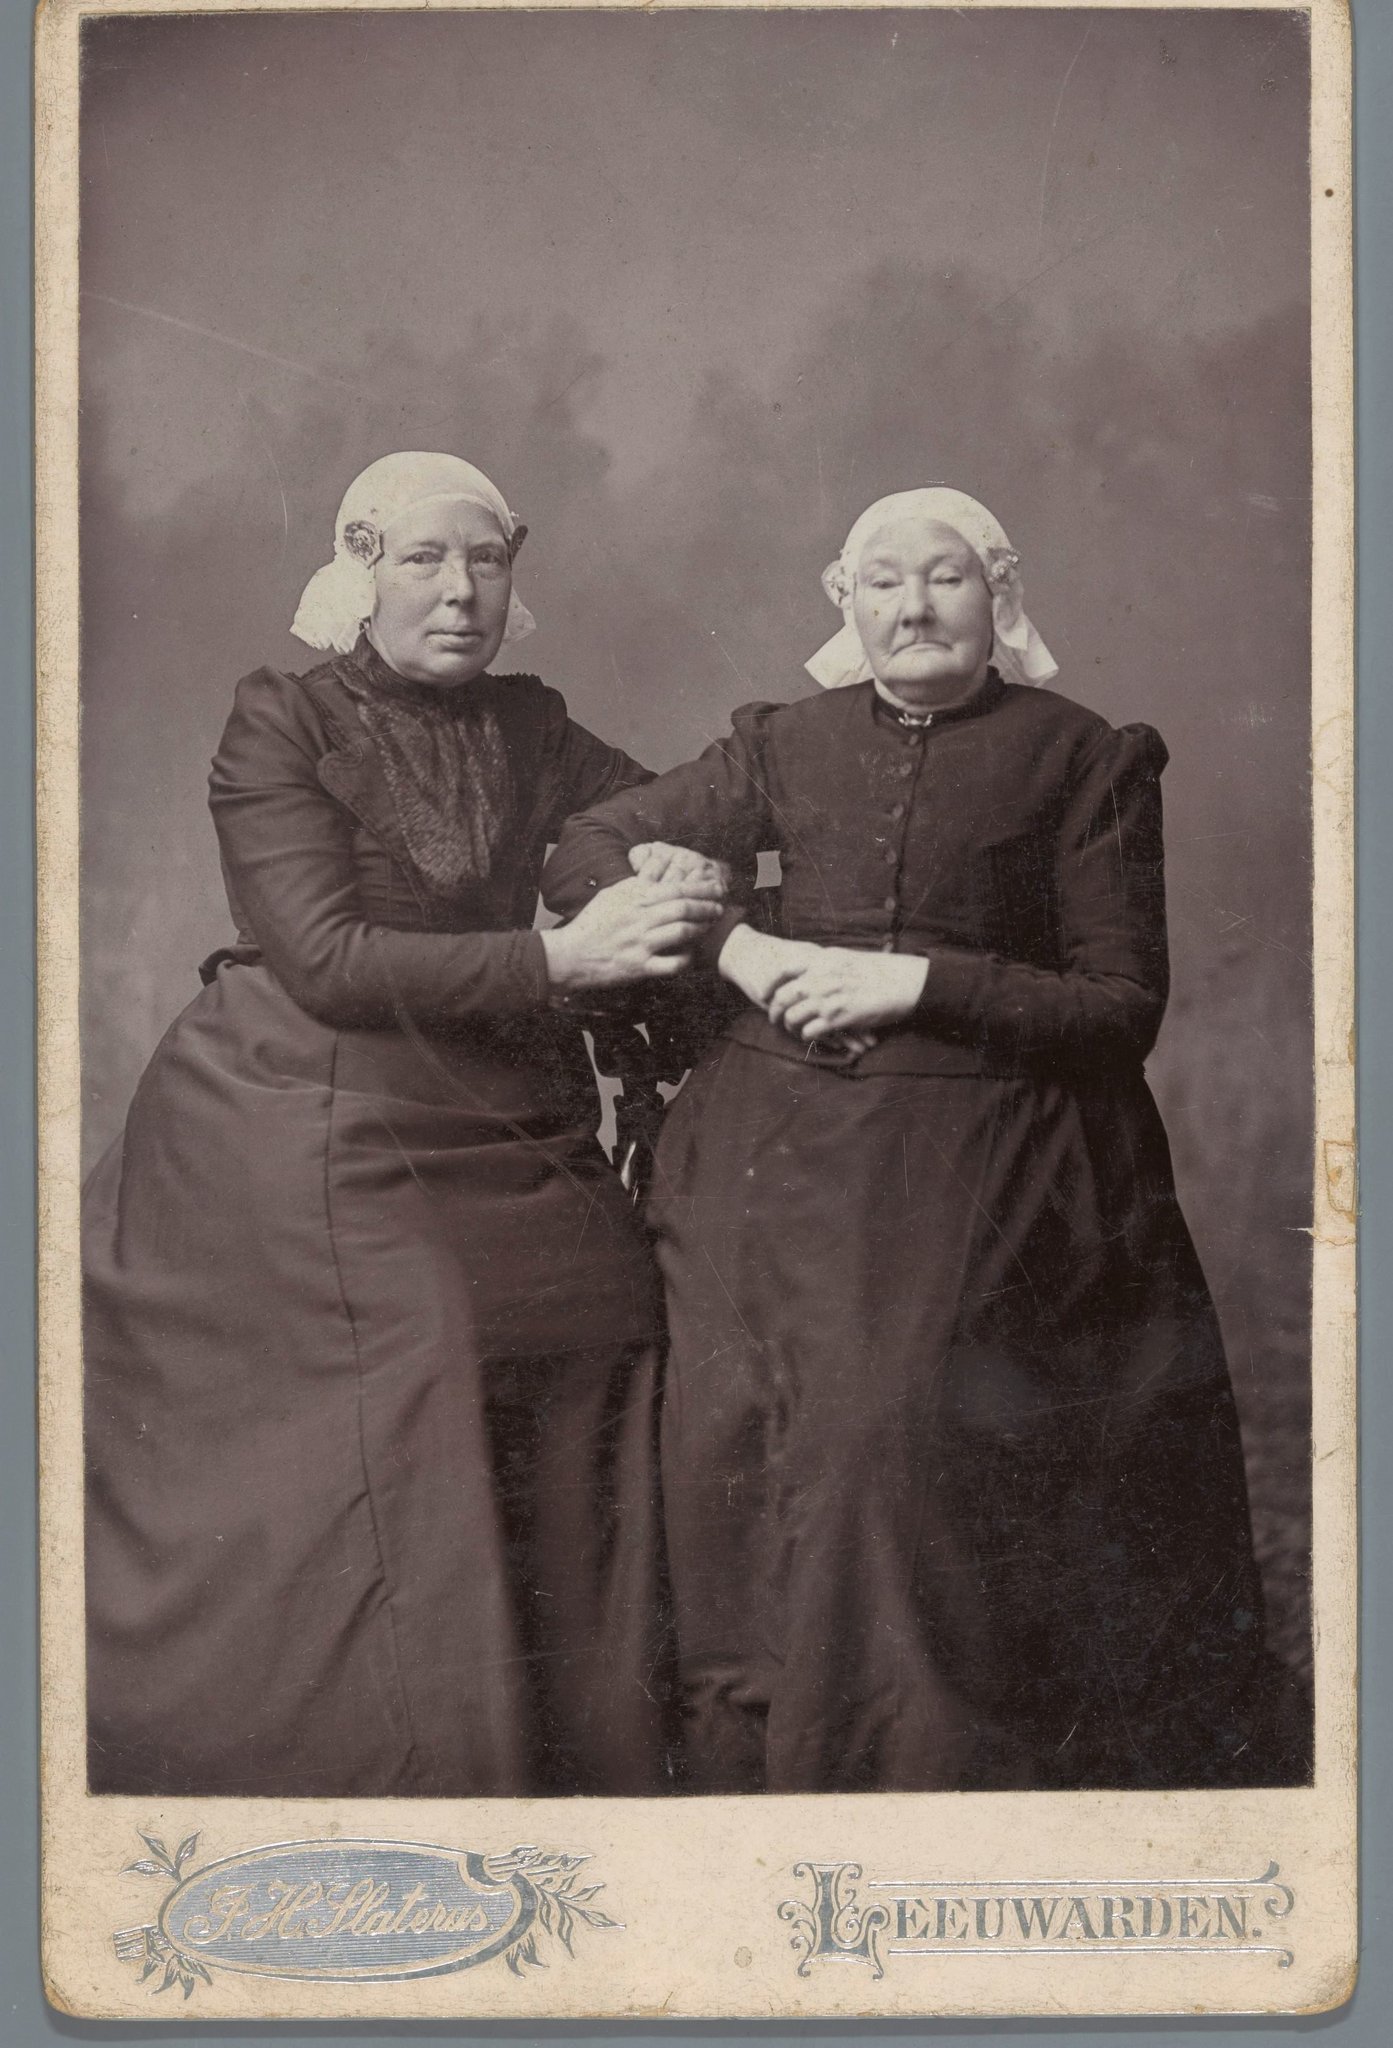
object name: cabinet photograph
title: Portret van twee onbekende vrouwen in Friese klederdracht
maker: idanus hendrikus slaterus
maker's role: fotograaf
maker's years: 1846-1921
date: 1890-1910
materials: cardboard, photographic support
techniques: gelatin silver print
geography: leeuwarden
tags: folk costume, regional costume, anonymous historical persons portrayed in a double portrait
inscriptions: inscription: ‘Atelier I. H. Slaterus Langemarkt-Straat Let. W. No. 14 tegen over het station. Specialiteit in Vergrootingen’